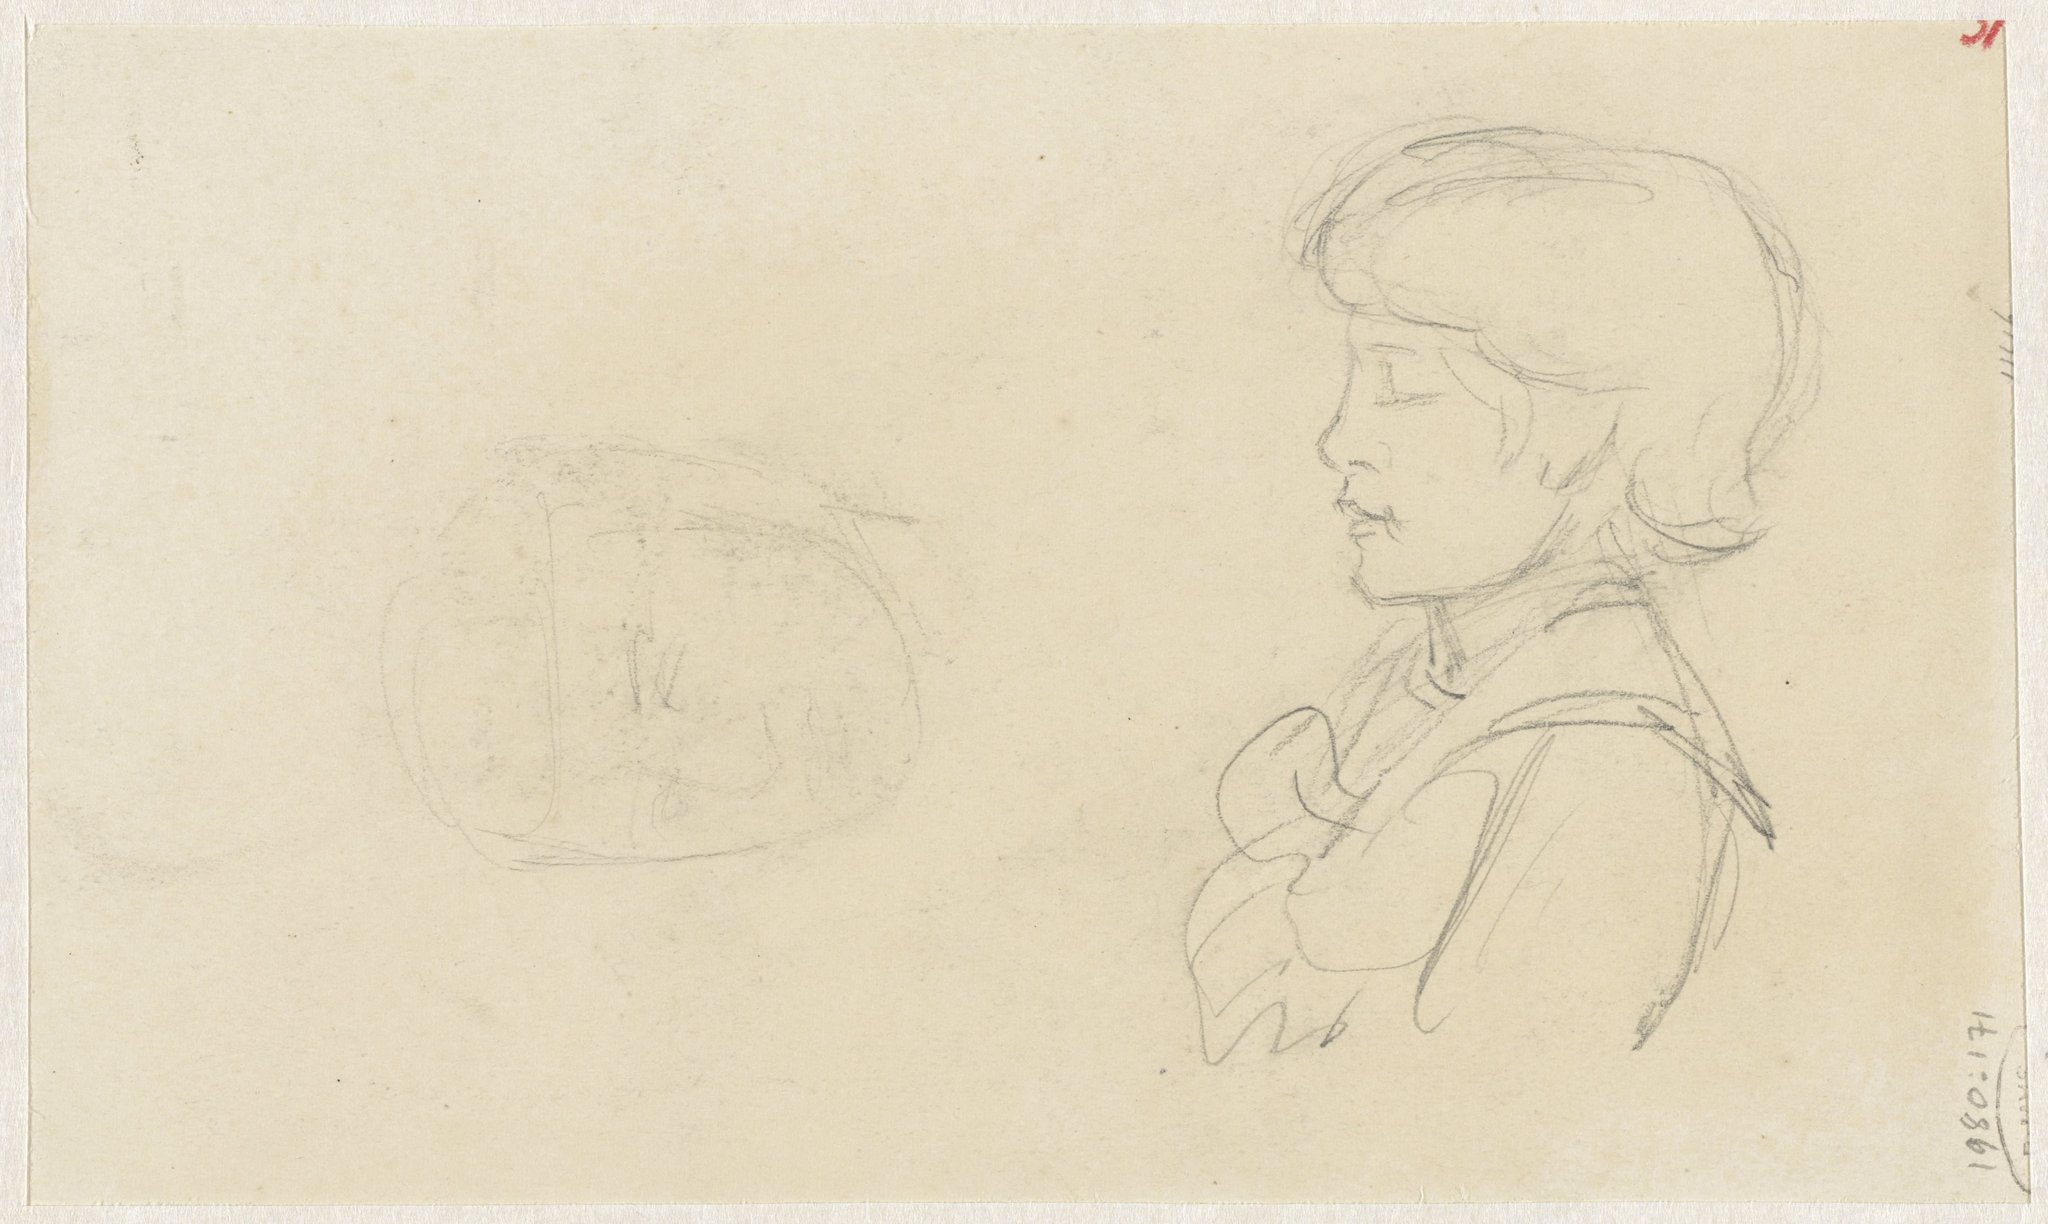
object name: drawing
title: Meisje van opzij en schets van een kop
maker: jozef israëls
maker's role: draughtsman, painter, print maker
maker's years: 1824-1911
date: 1834-1911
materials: paper, pencil